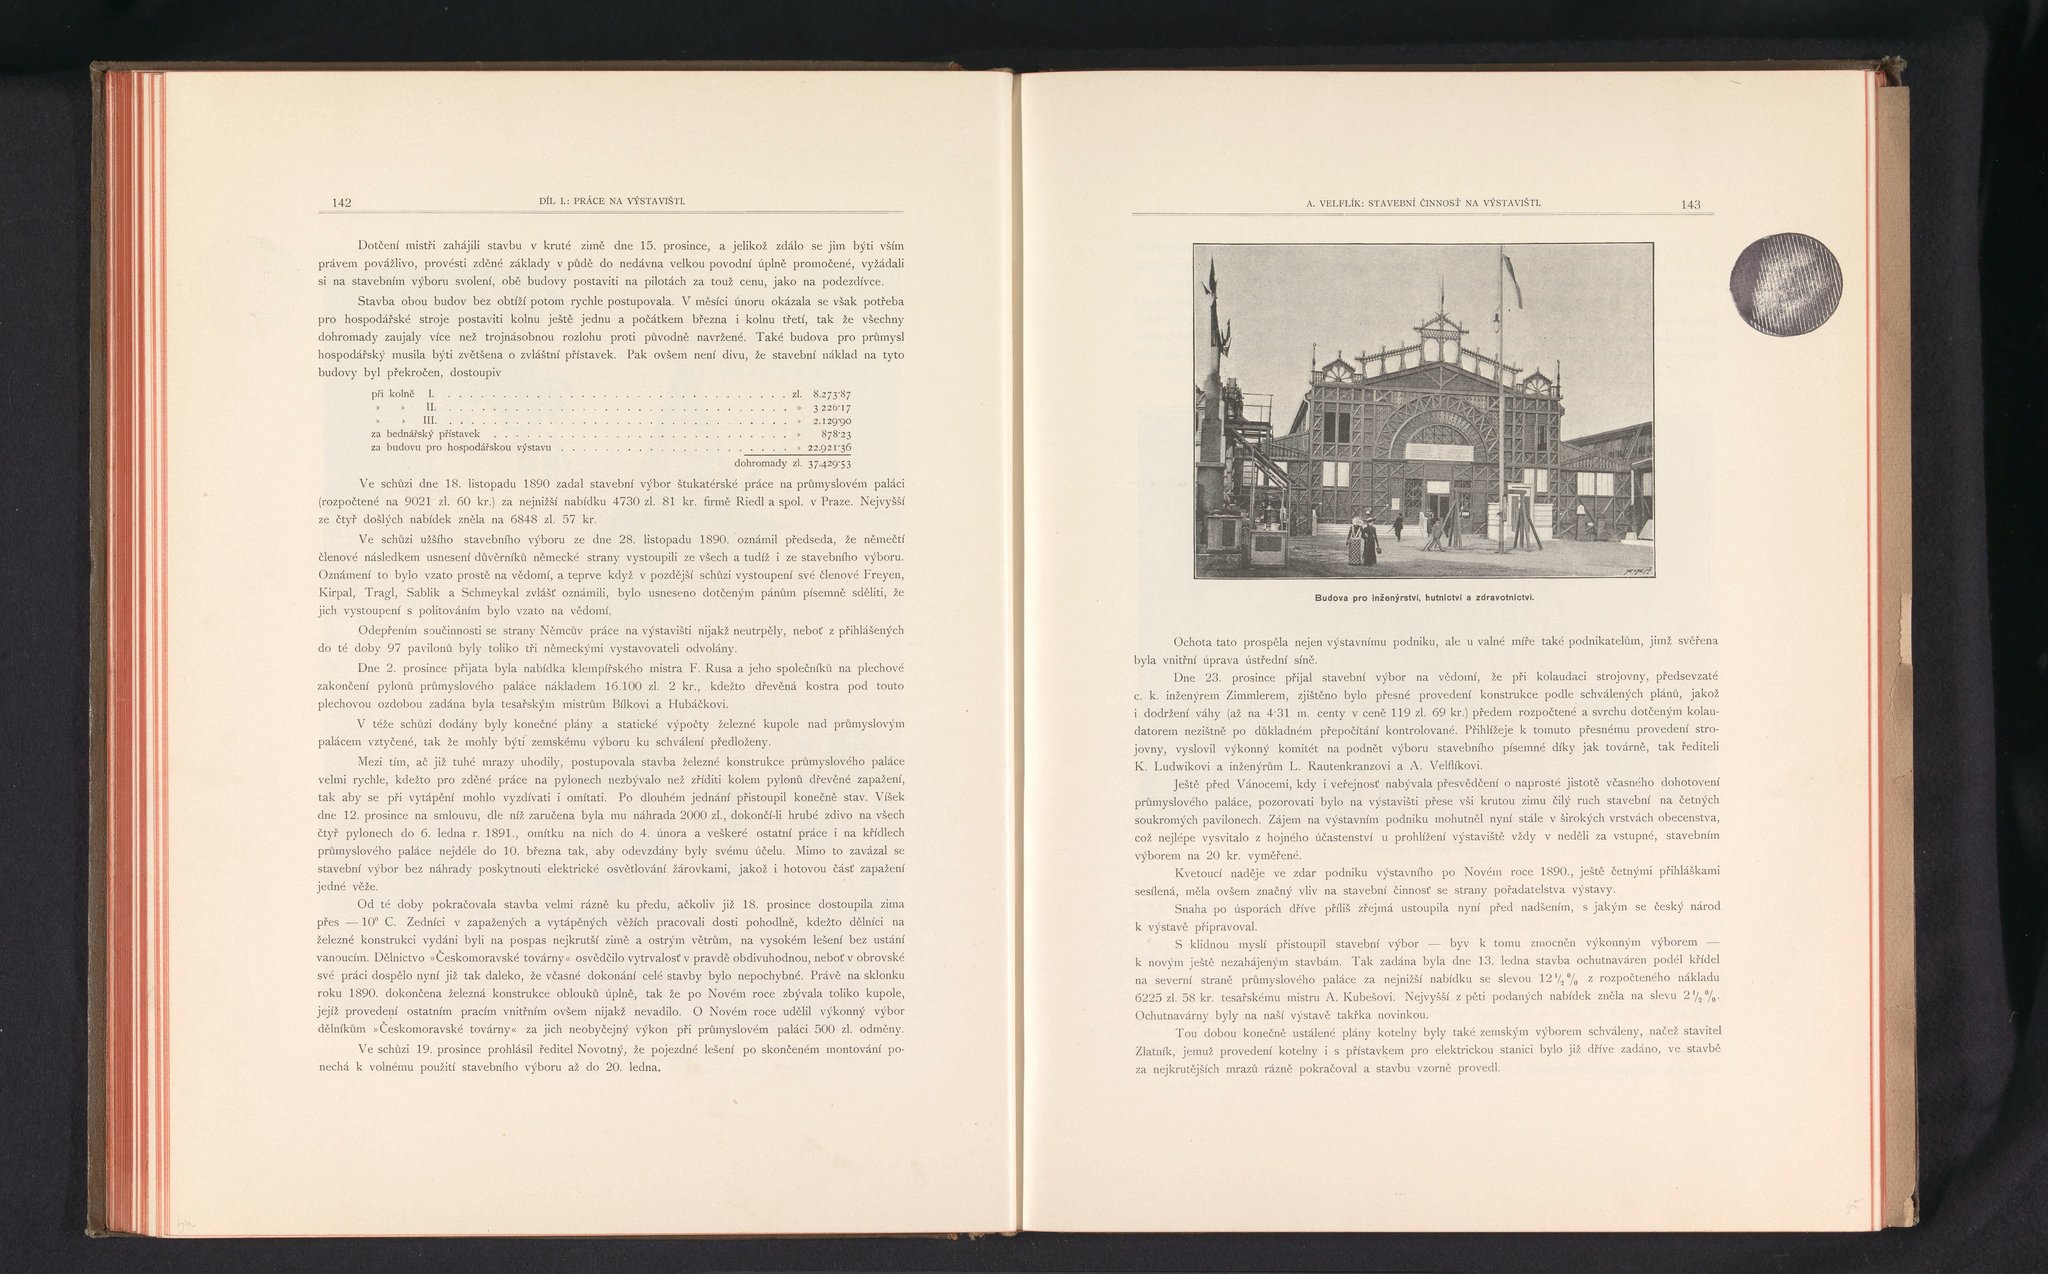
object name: photomechanical print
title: Budova pro inzenýrstvi, hutnictvi a zdravotnictvi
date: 1888-1893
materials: paper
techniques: autotype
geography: výstaviště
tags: façade (of house or building), temporary exhibition, 'salon'